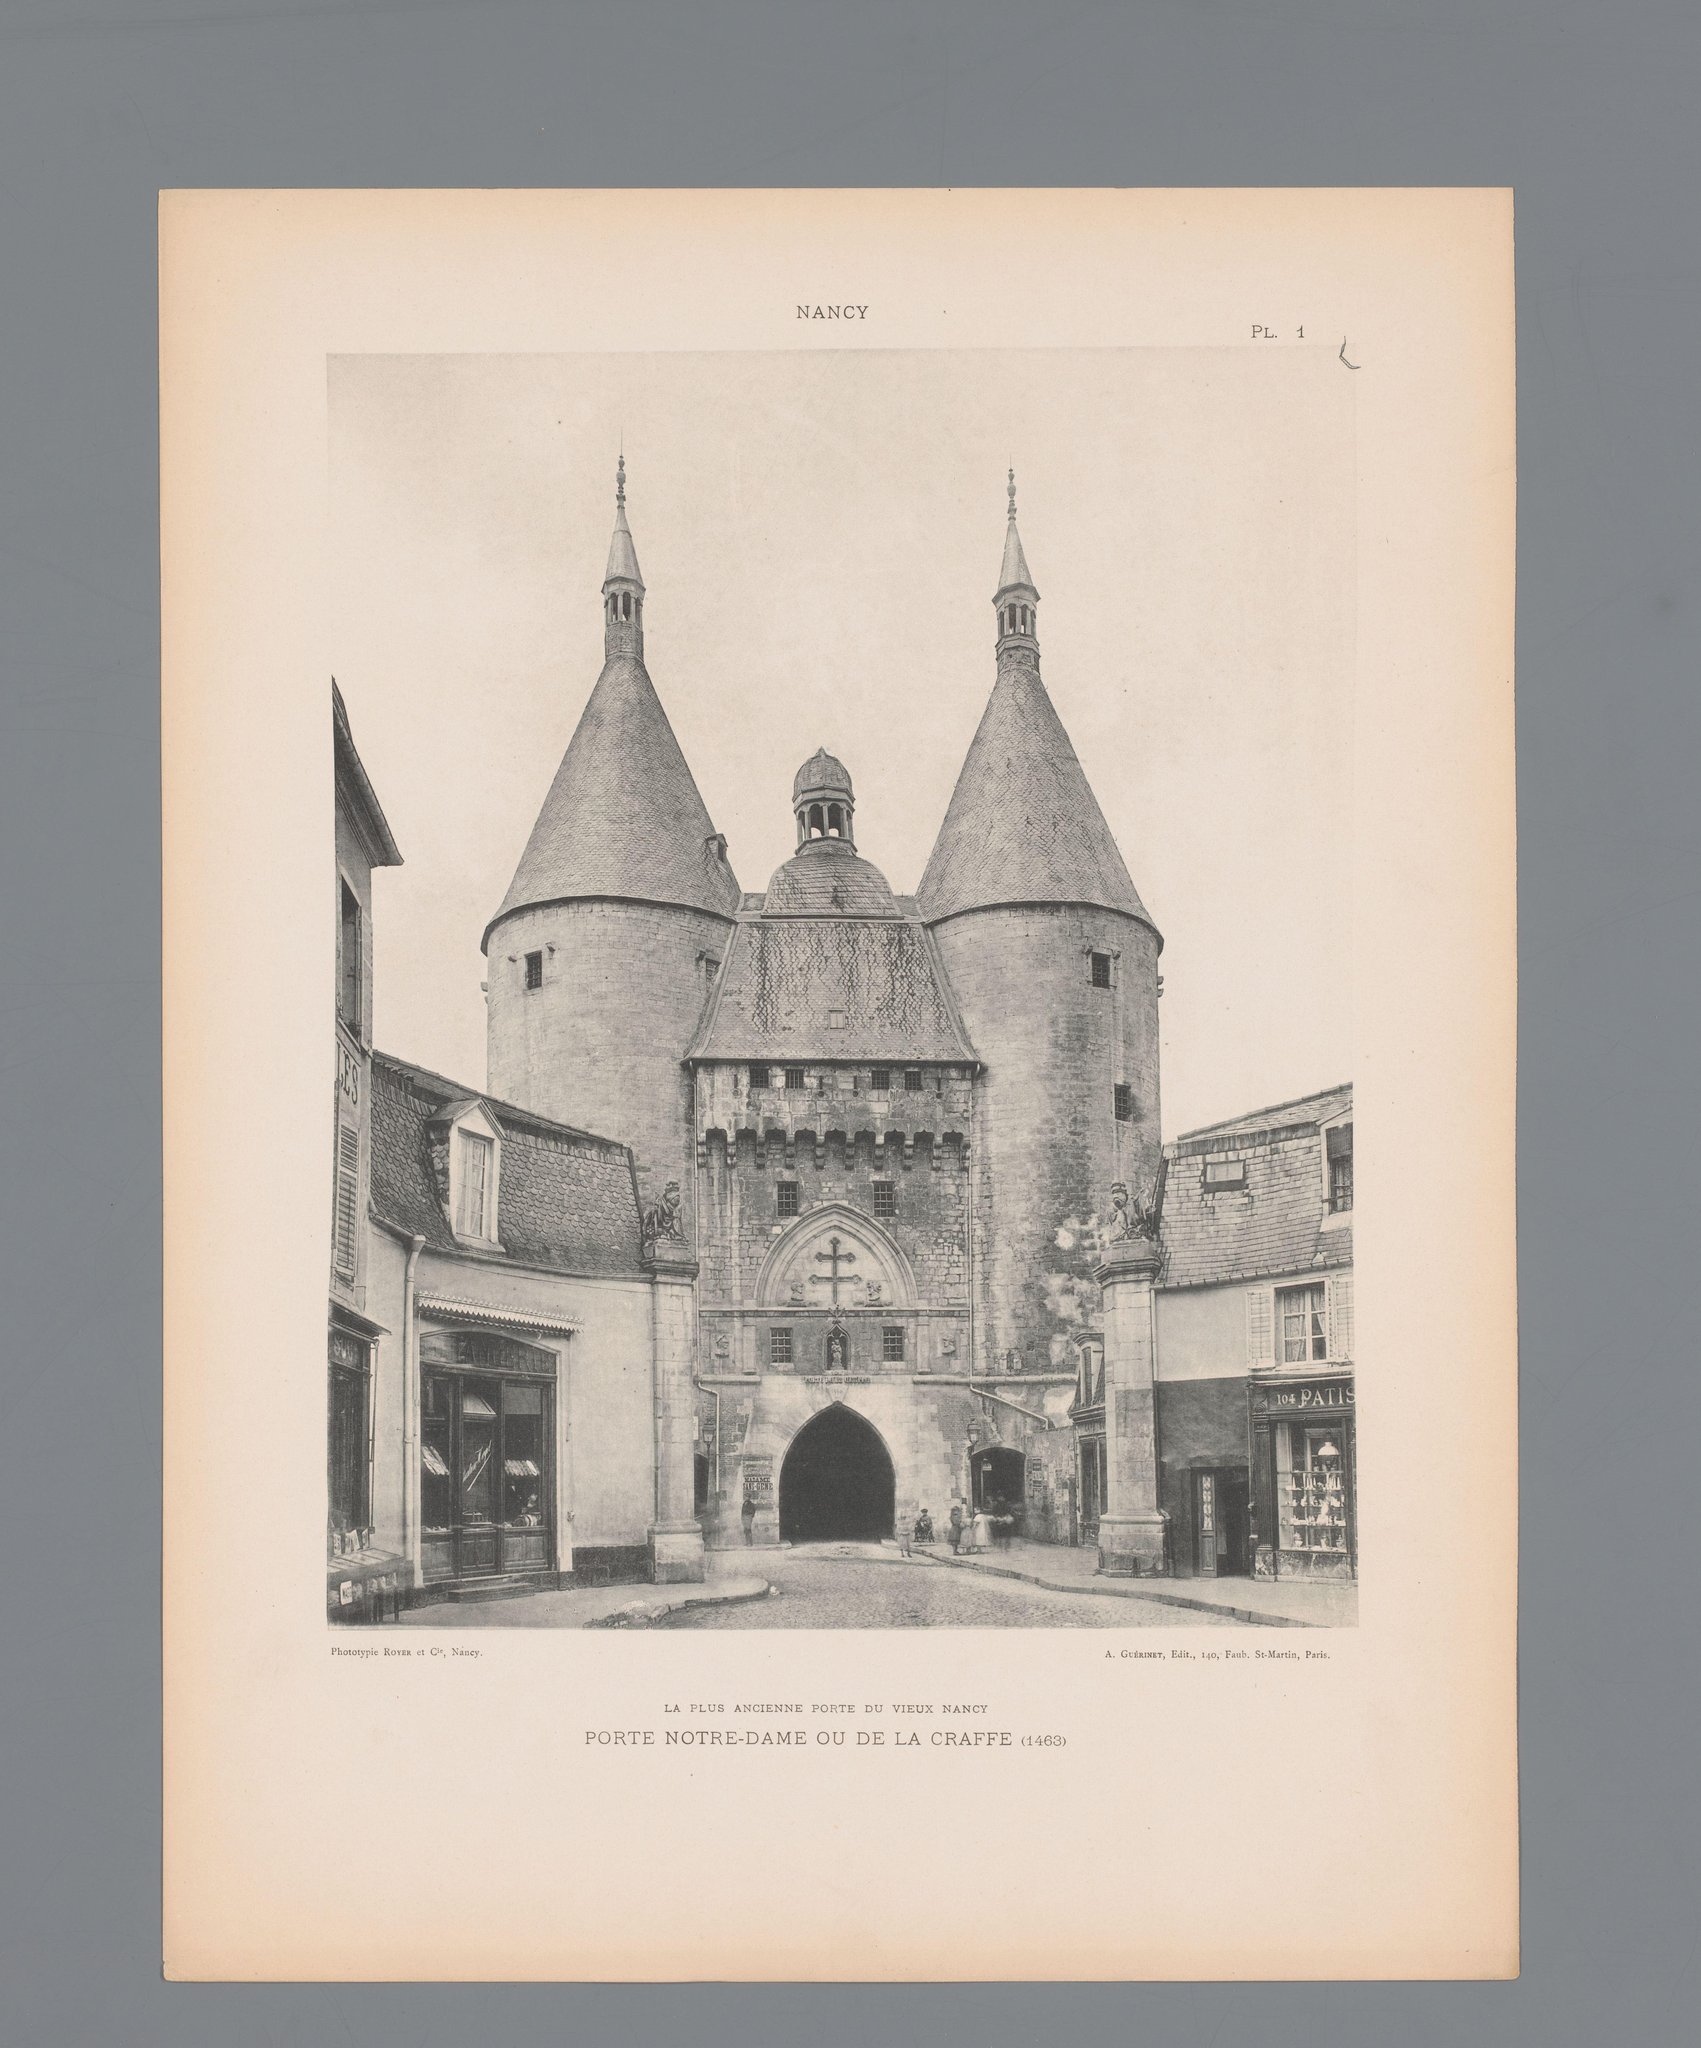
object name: photomechanical print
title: Gezicht op de Porte de la Craffe te Nancy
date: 1891-1896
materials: paper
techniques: photograph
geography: nancy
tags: city-gate (+ city(-scape) with figures, staffage)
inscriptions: inscription: ‘Porte Notre-Dame ou de la Craffe (1463)’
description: Deze prent maakt deel uit van een omslag met 103 prenten op 101 bladen en een titelblad.